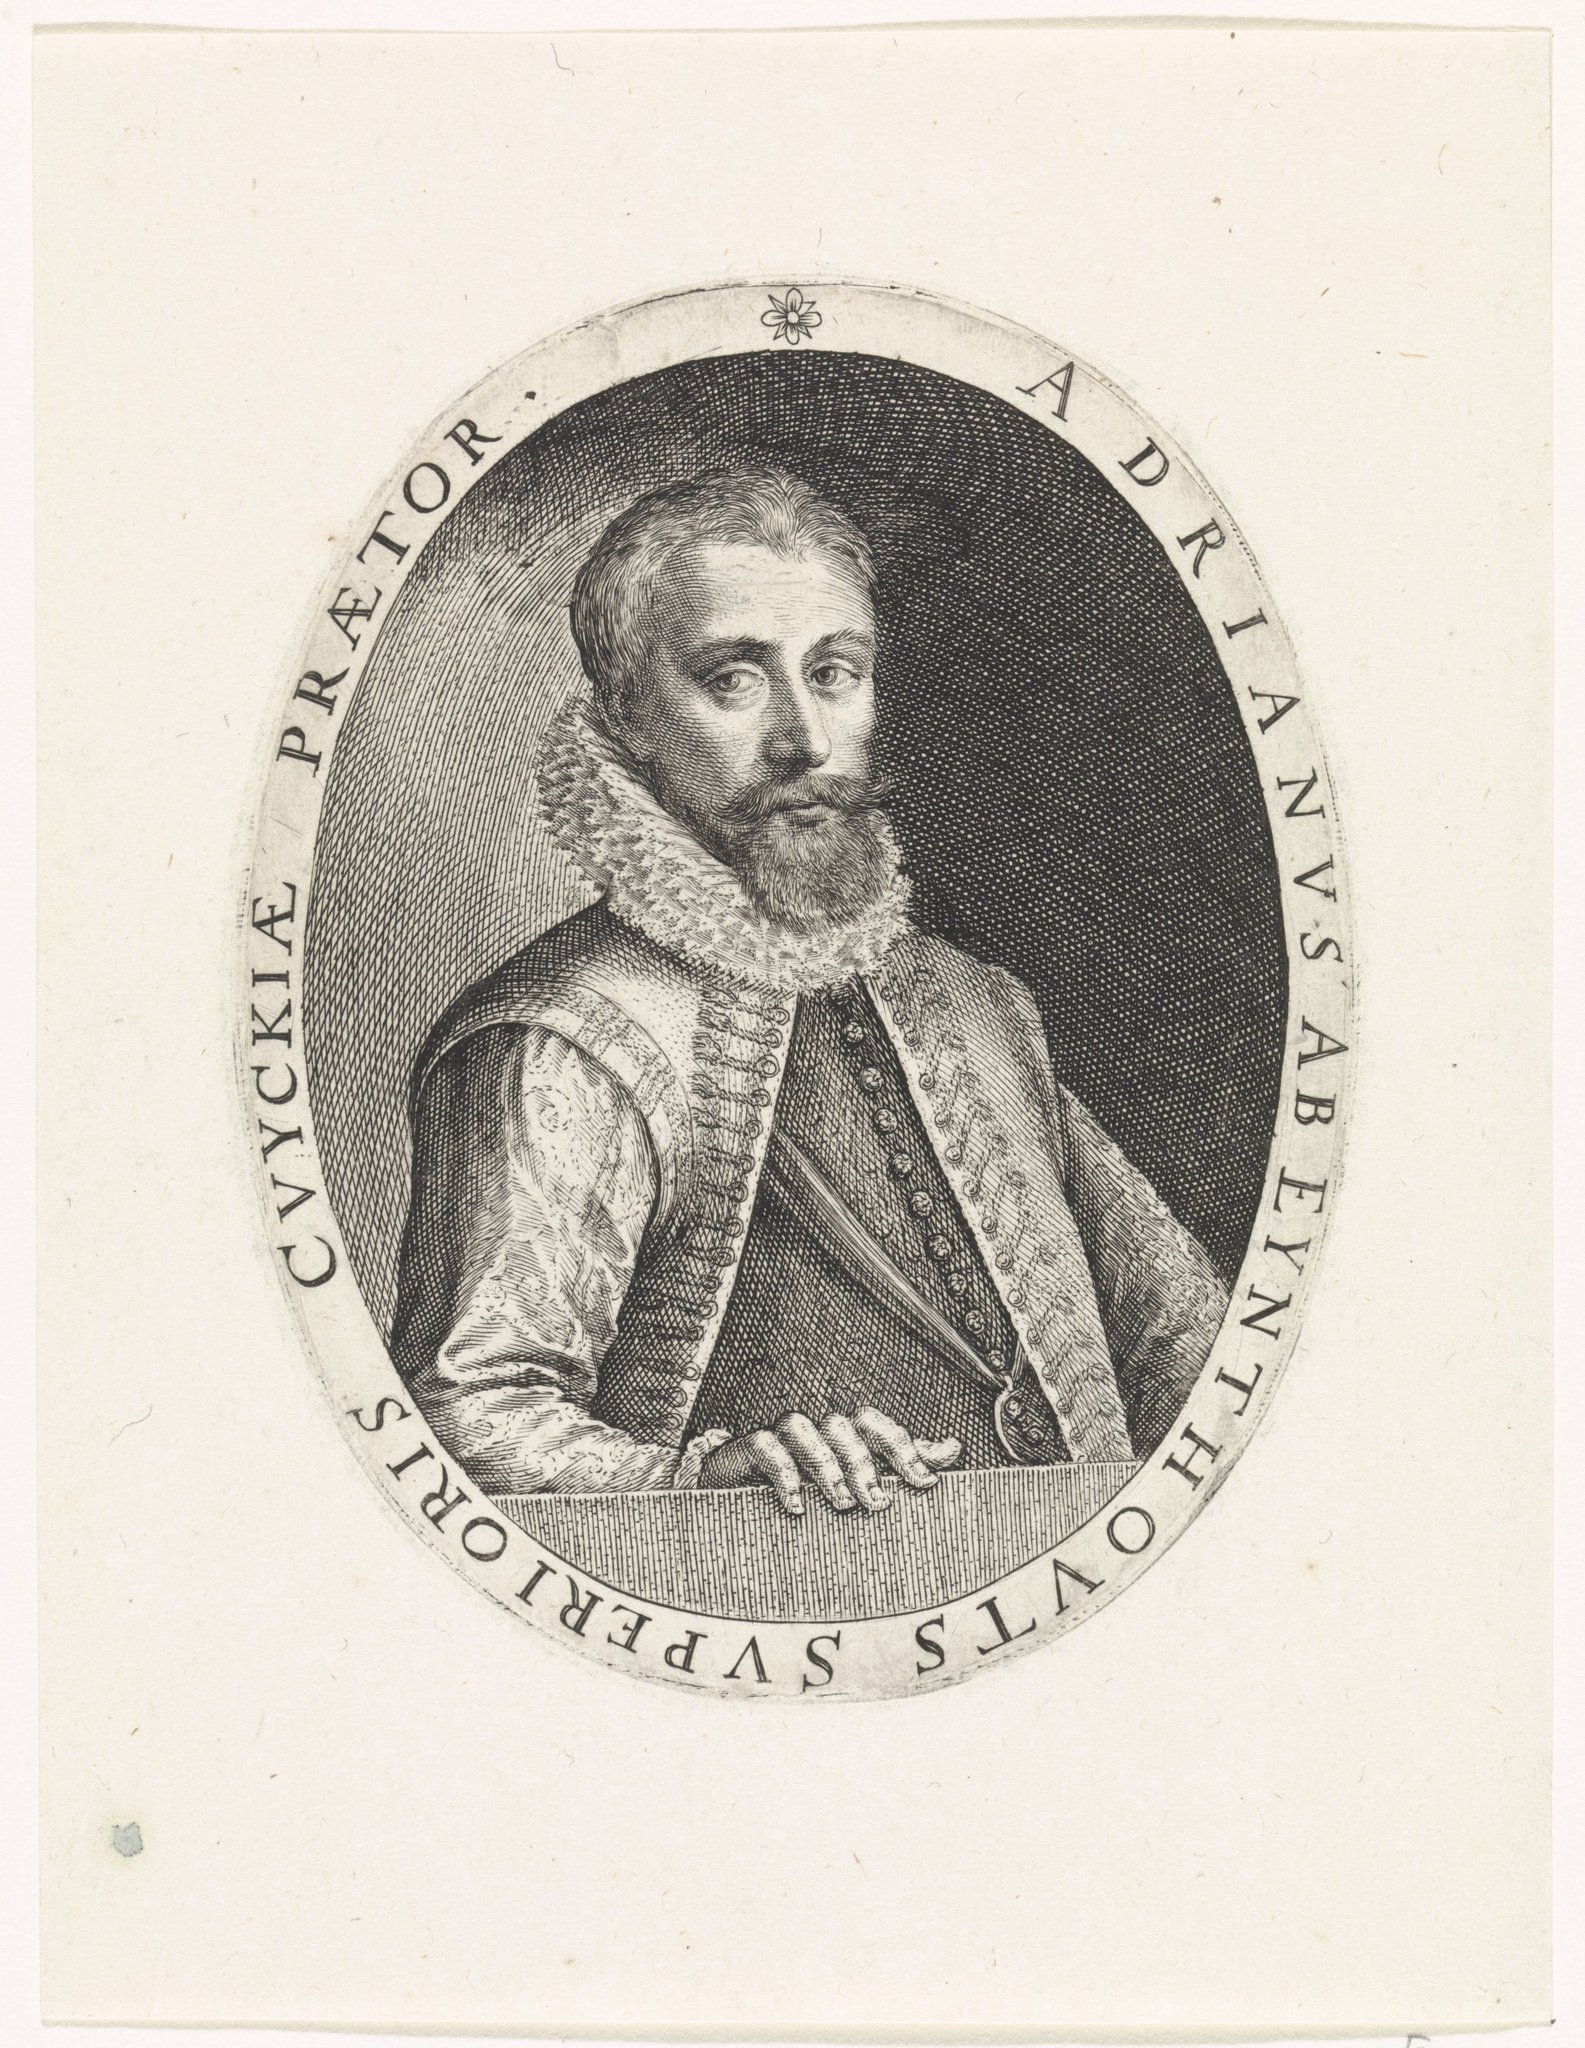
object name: print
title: Portret van Adriaan van Eynthouts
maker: crispijn van de passe (i)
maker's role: draughtsman, print maker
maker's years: 1564-1637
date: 1574-1637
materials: paper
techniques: engraving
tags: schout, adriaan van eynthouts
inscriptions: collector's mark: Lugt 2228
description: Portret van Adriaan van Eynthouts, schout van Cuyk. In het randschrift van de omlijsting de naam en functie van de geportretteerde in het Latijn.